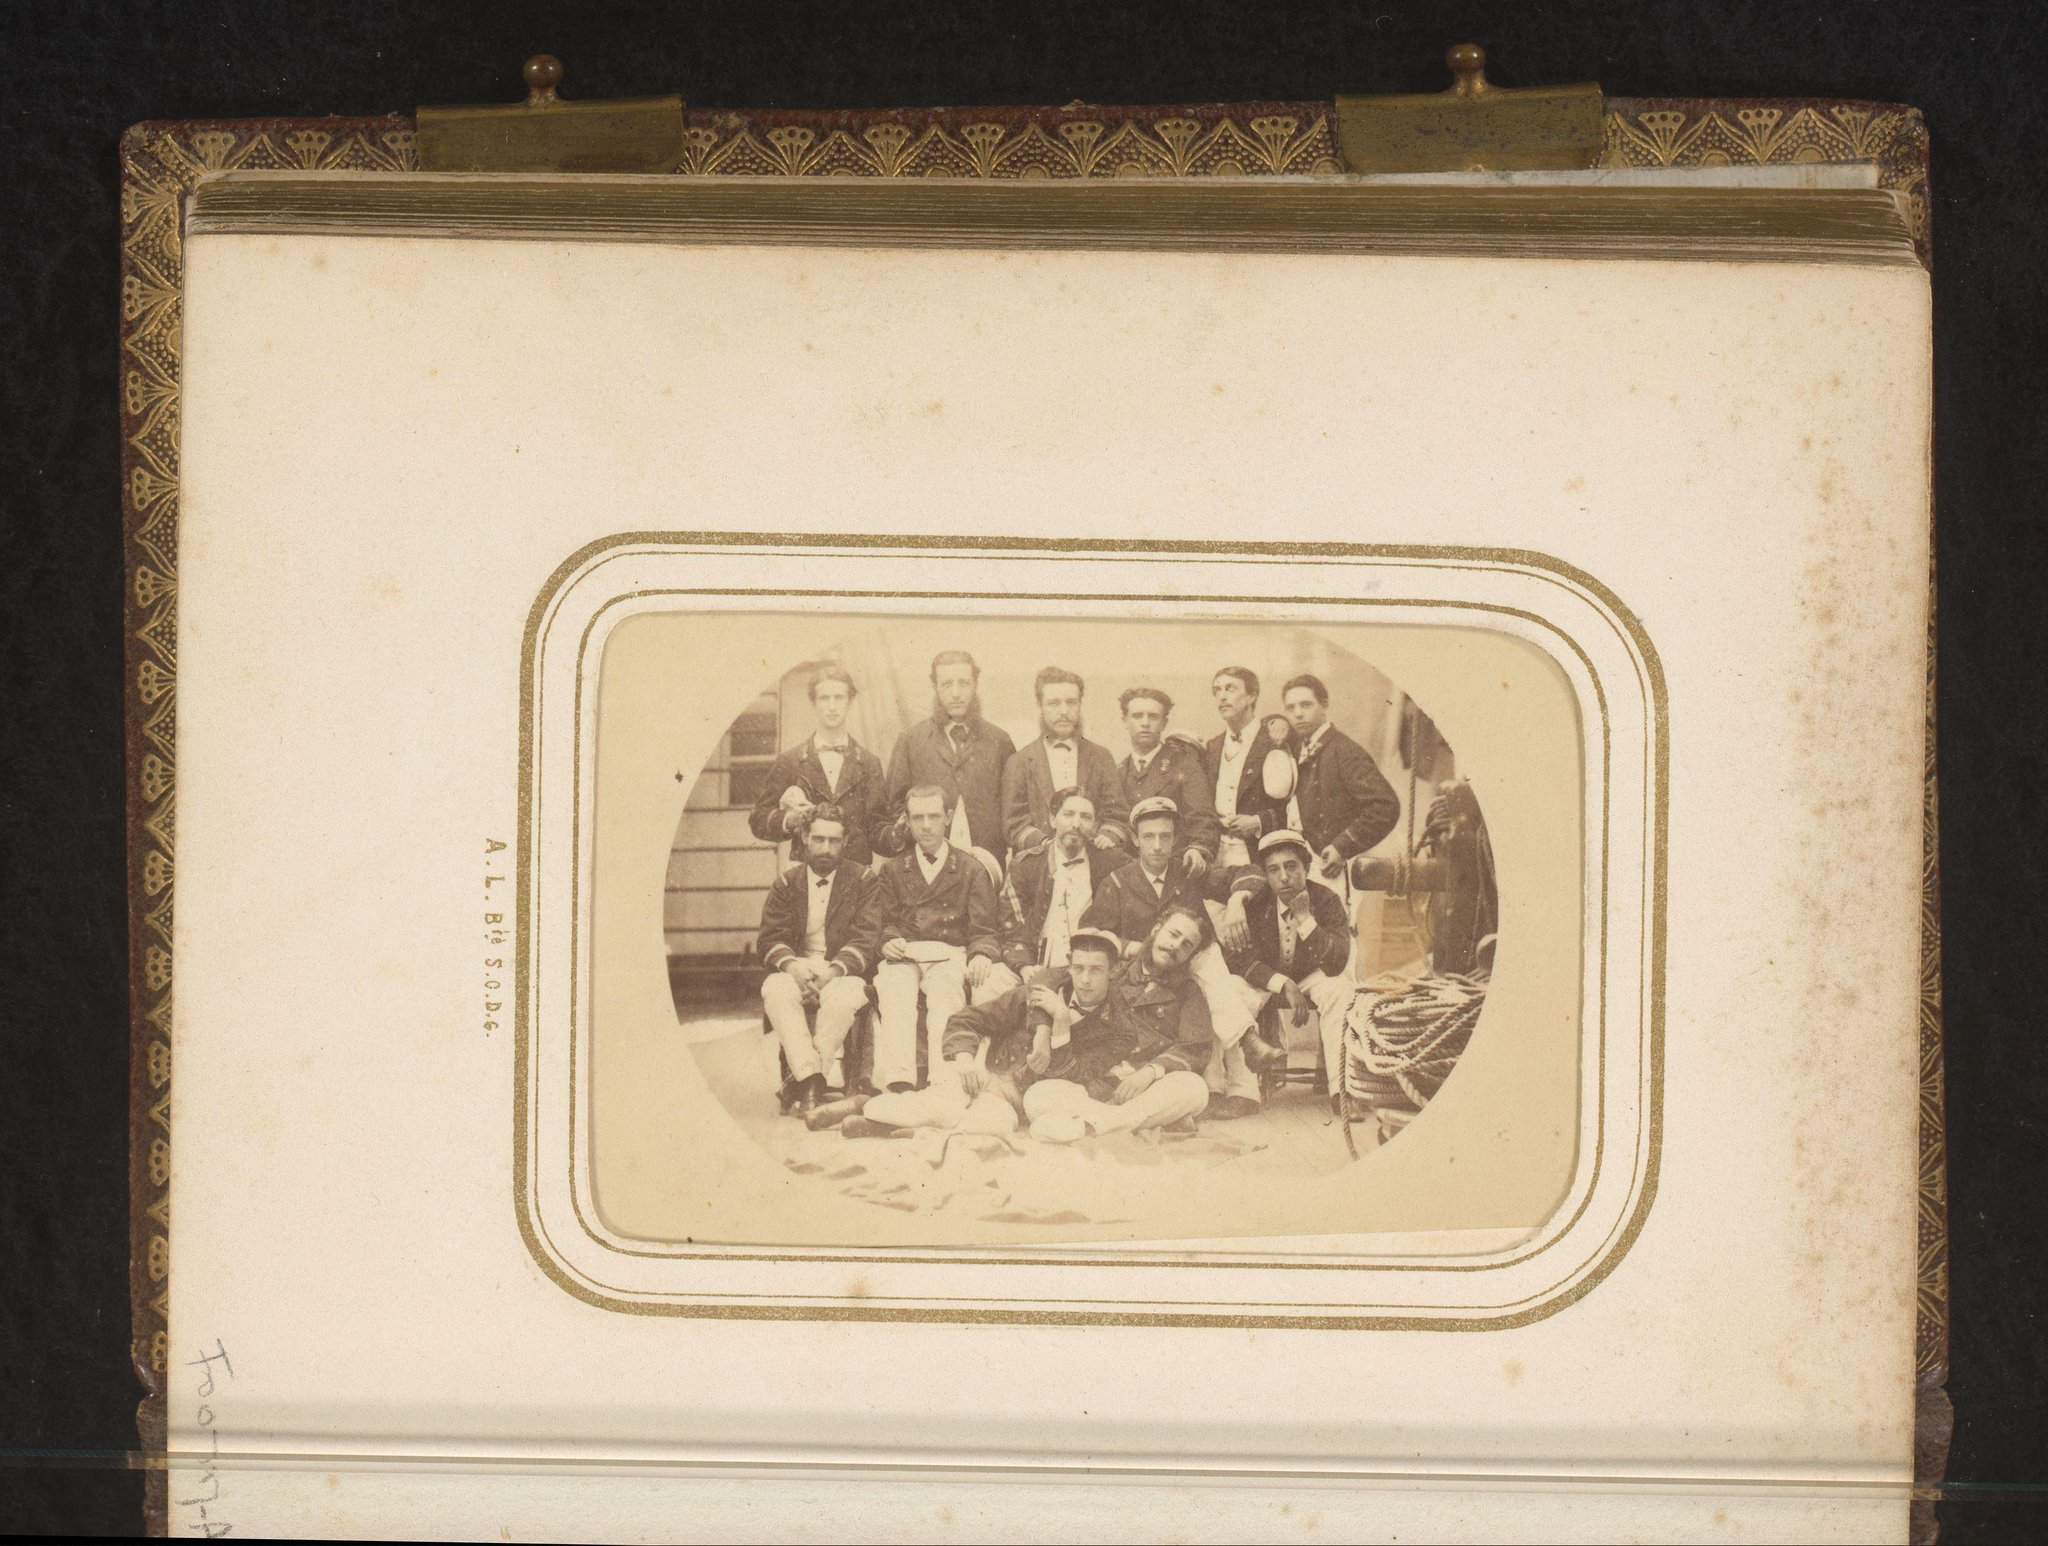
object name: carte de visite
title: Groepsportret van bemanningsleden aan boord van een schip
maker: marc ferrez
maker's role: fotograaf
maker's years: 1843-1923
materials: cardboard, photographic support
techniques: albumen print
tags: crew ~ ship, anonymous historical persons portrayed in a group, in a group-portrait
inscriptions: inscription: ‘Photographia Brazilleira/ Marc Ferrez/ Phtoographo da Marinha Imperal/ e das Construccões Navaes do/ Rio de Janeiro/ 96 Rua de S. José 96/ Rio de Janeiro’, inscription: ‘A.L. B.te S.C.D.G.’